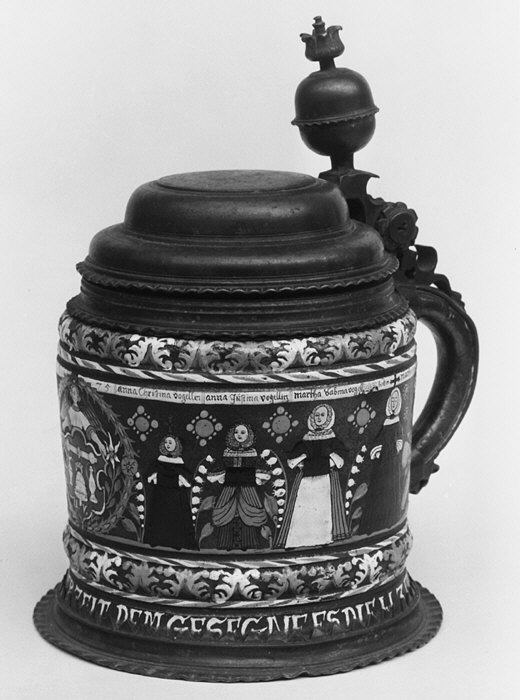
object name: tankard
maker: johannes vogel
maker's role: artist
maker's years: 1625-1725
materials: pewter, stoneware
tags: women